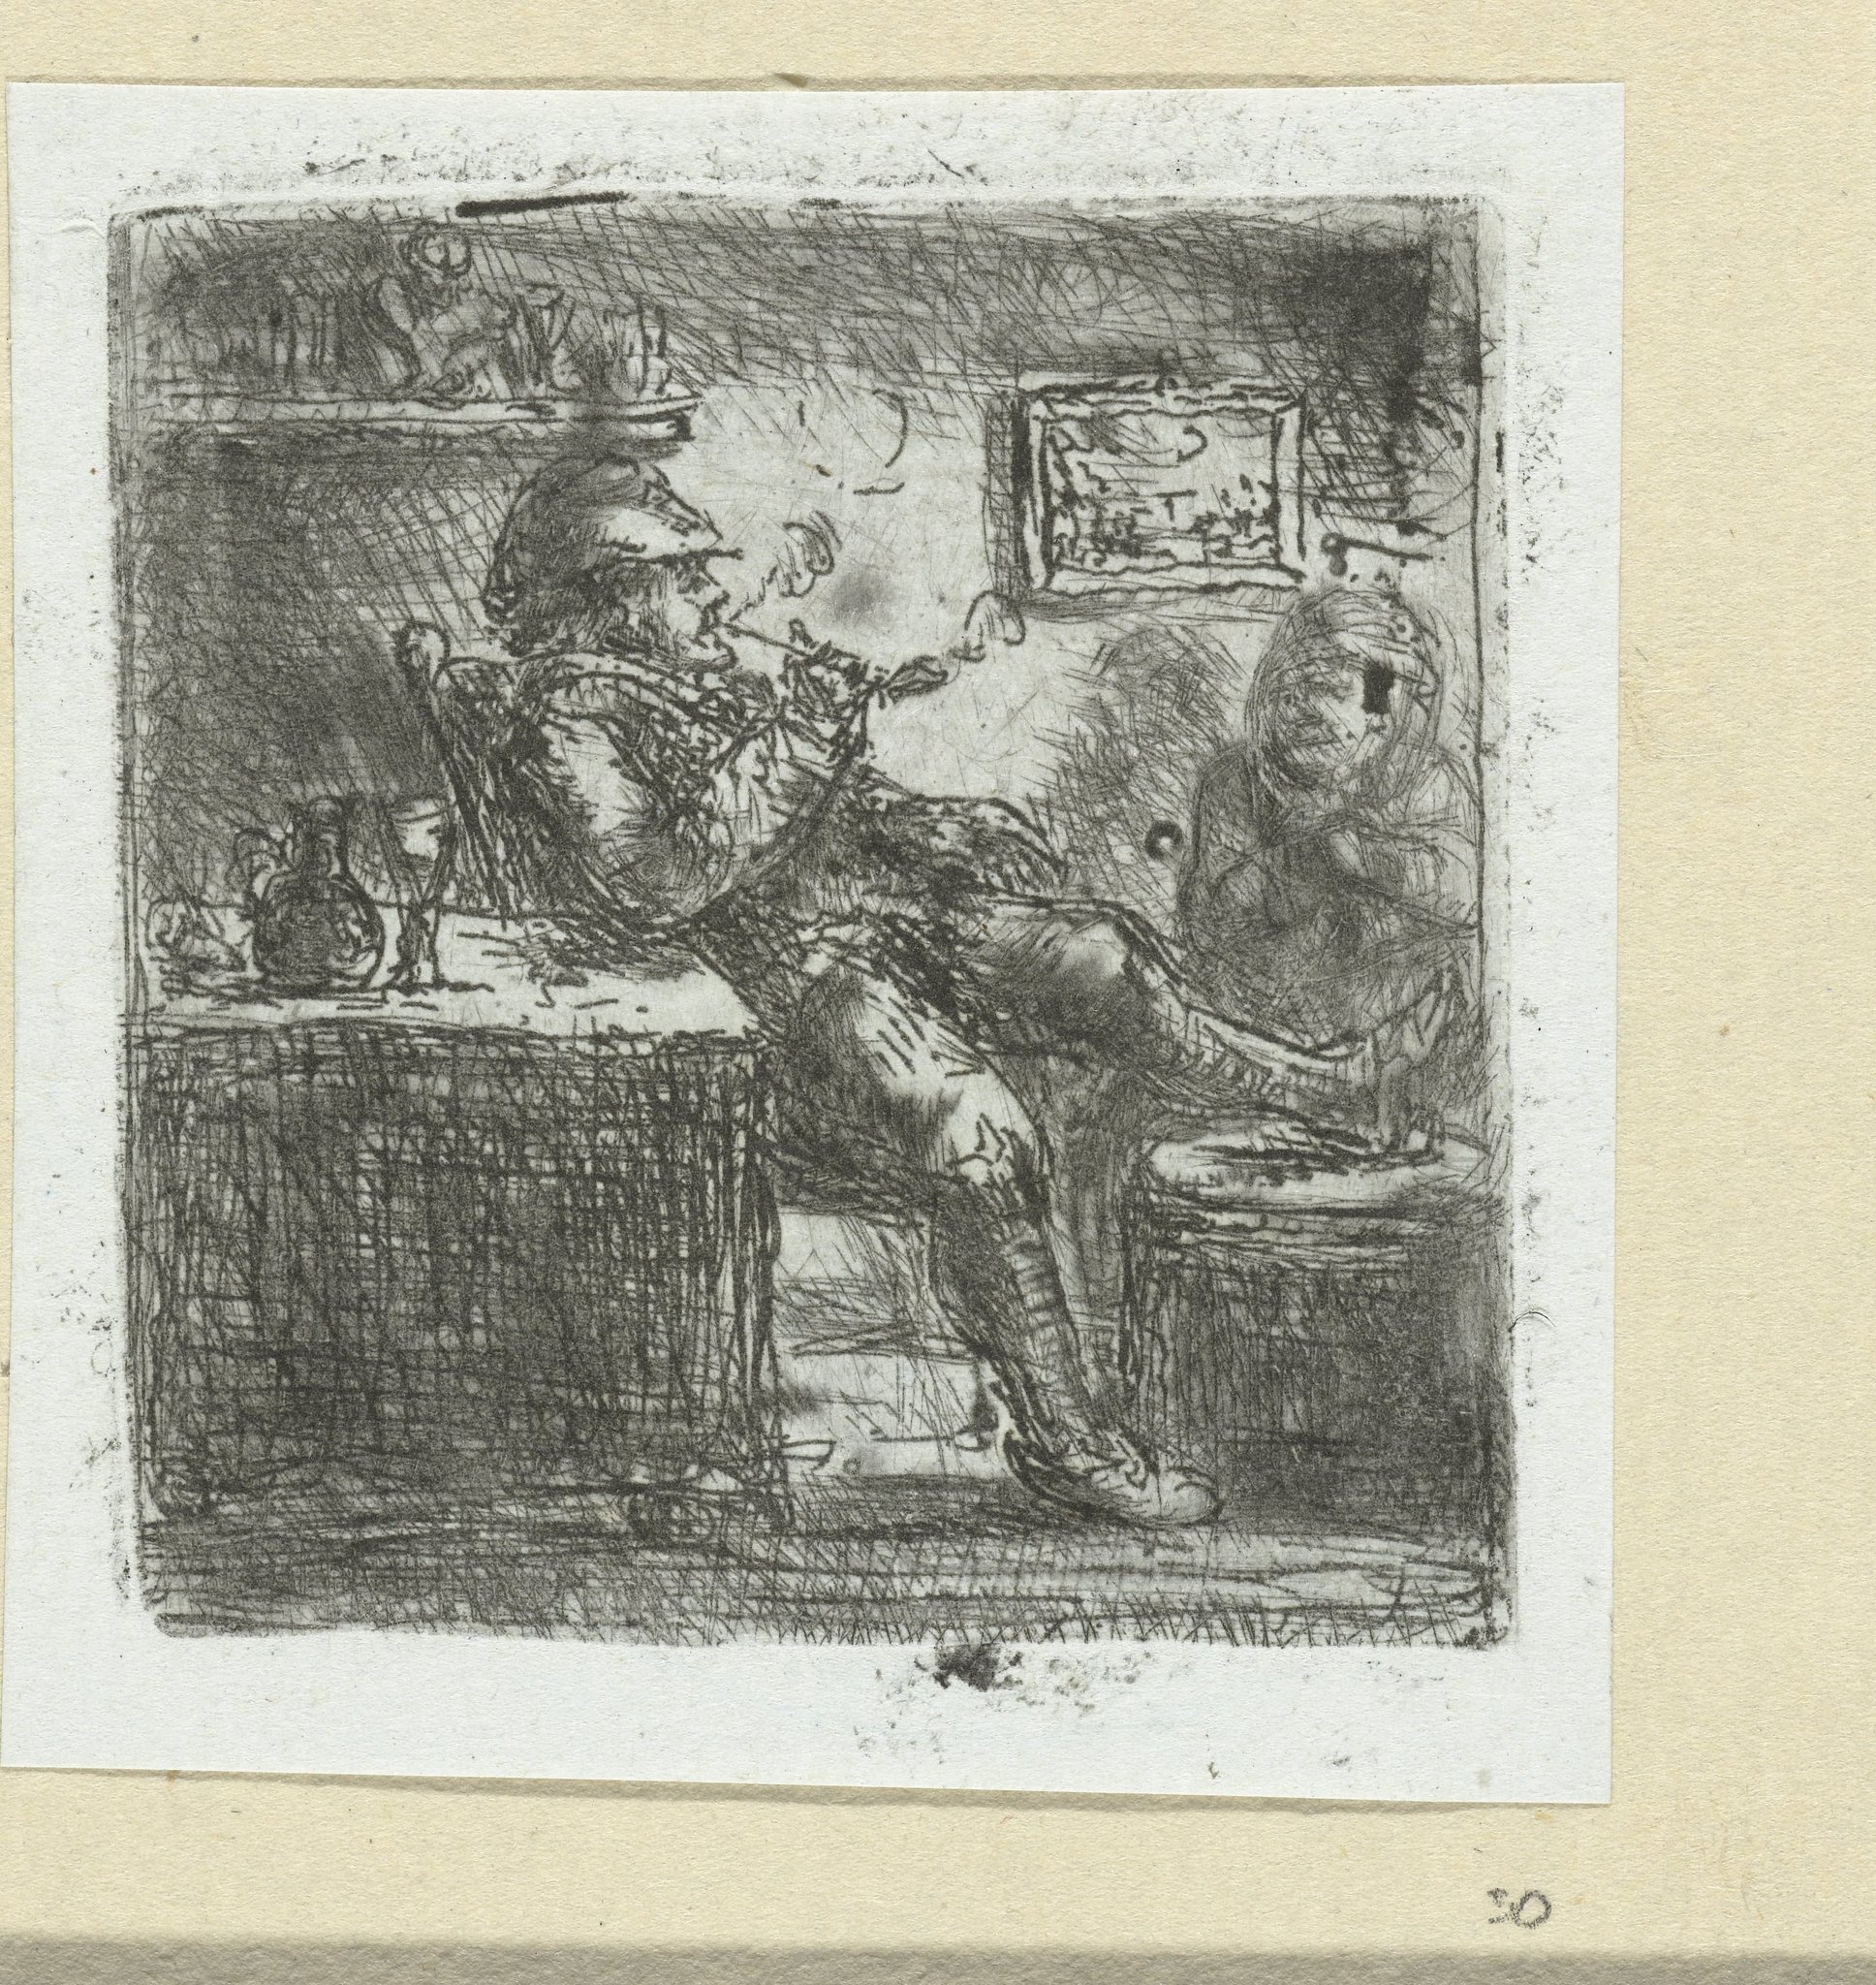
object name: print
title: Man met pijp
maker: jan chalon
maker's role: print maker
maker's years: 1738-1795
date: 1748-1795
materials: paper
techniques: drypoint, etching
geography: northern netherlands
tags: pipe ~ tobacco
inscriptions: collector's mark: Lugt 924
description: Interieur van een kamer. Een man zit languit op een stoel en rookt een pijp. Een gast komt binnen.